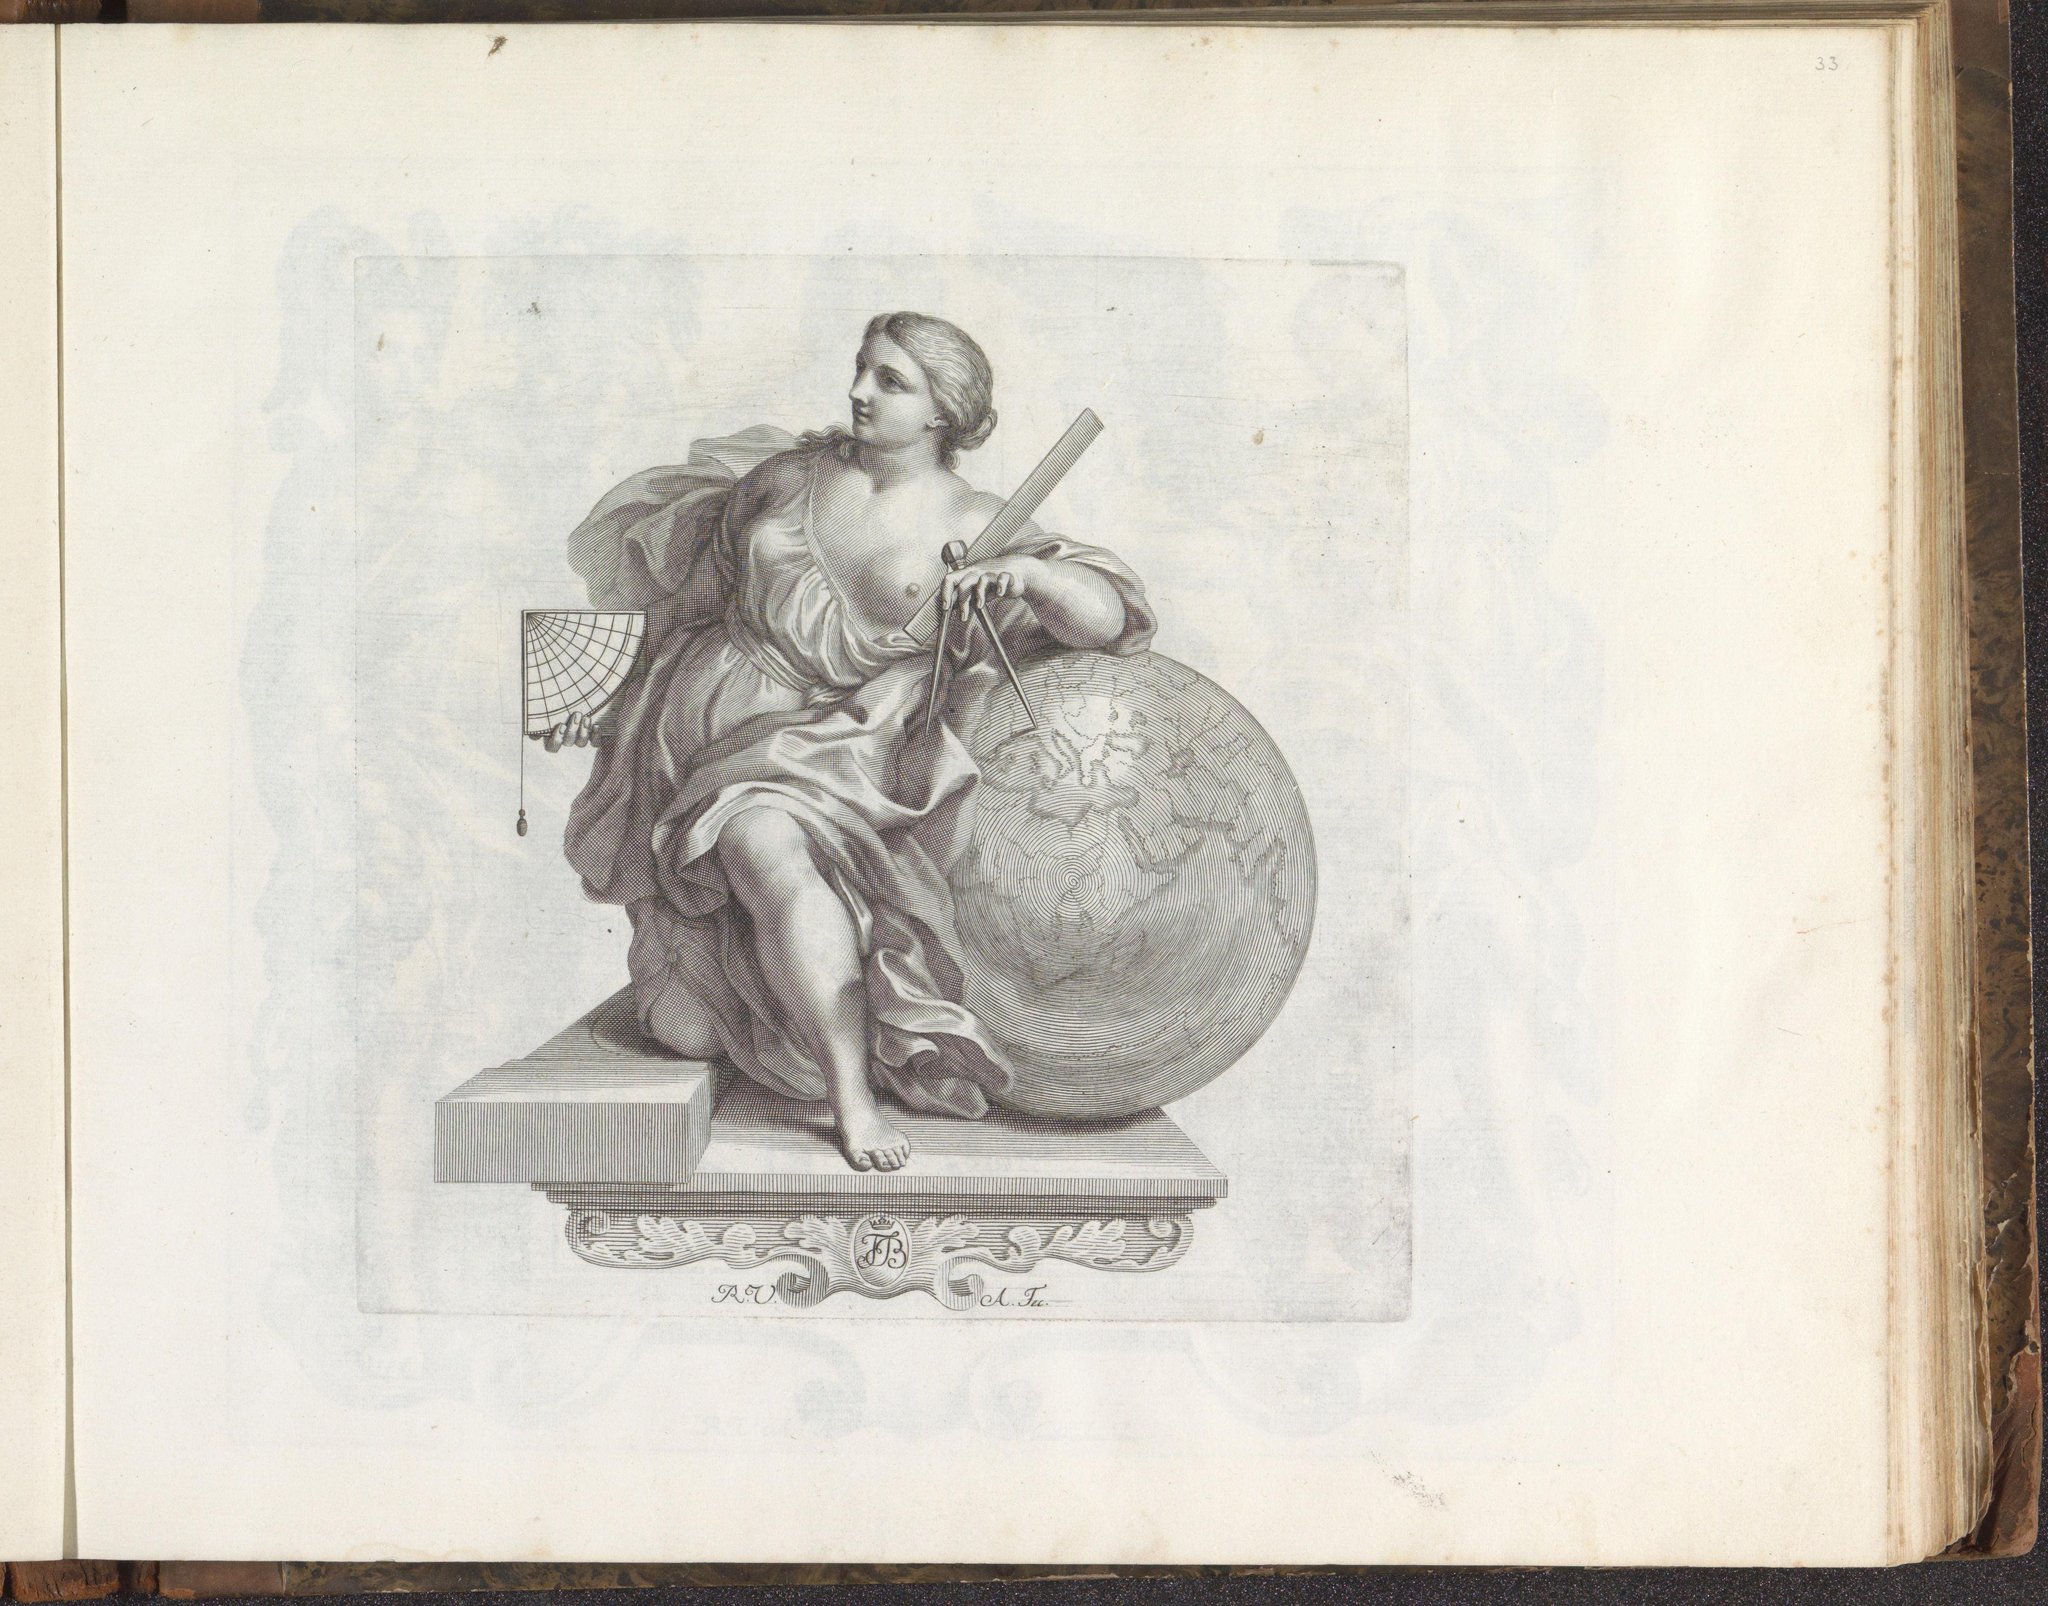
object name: album leaf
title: Personificatie van de Geografie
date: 1673-1743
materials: paper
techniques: engraving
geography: rome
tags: 'corografia', 'geografia', 'hidrografia' (ripa)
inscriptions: collector's mark: Lugt 2228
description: Een console met een vrouw als personificatie van Geografie of Landbeschrijving. In haar hand heeft ze een passer waarmee de wereldbol wil opmeten. In haar andere hand houdt ze een geometrisch kwadrant. De prent maakt deel uit van een album.